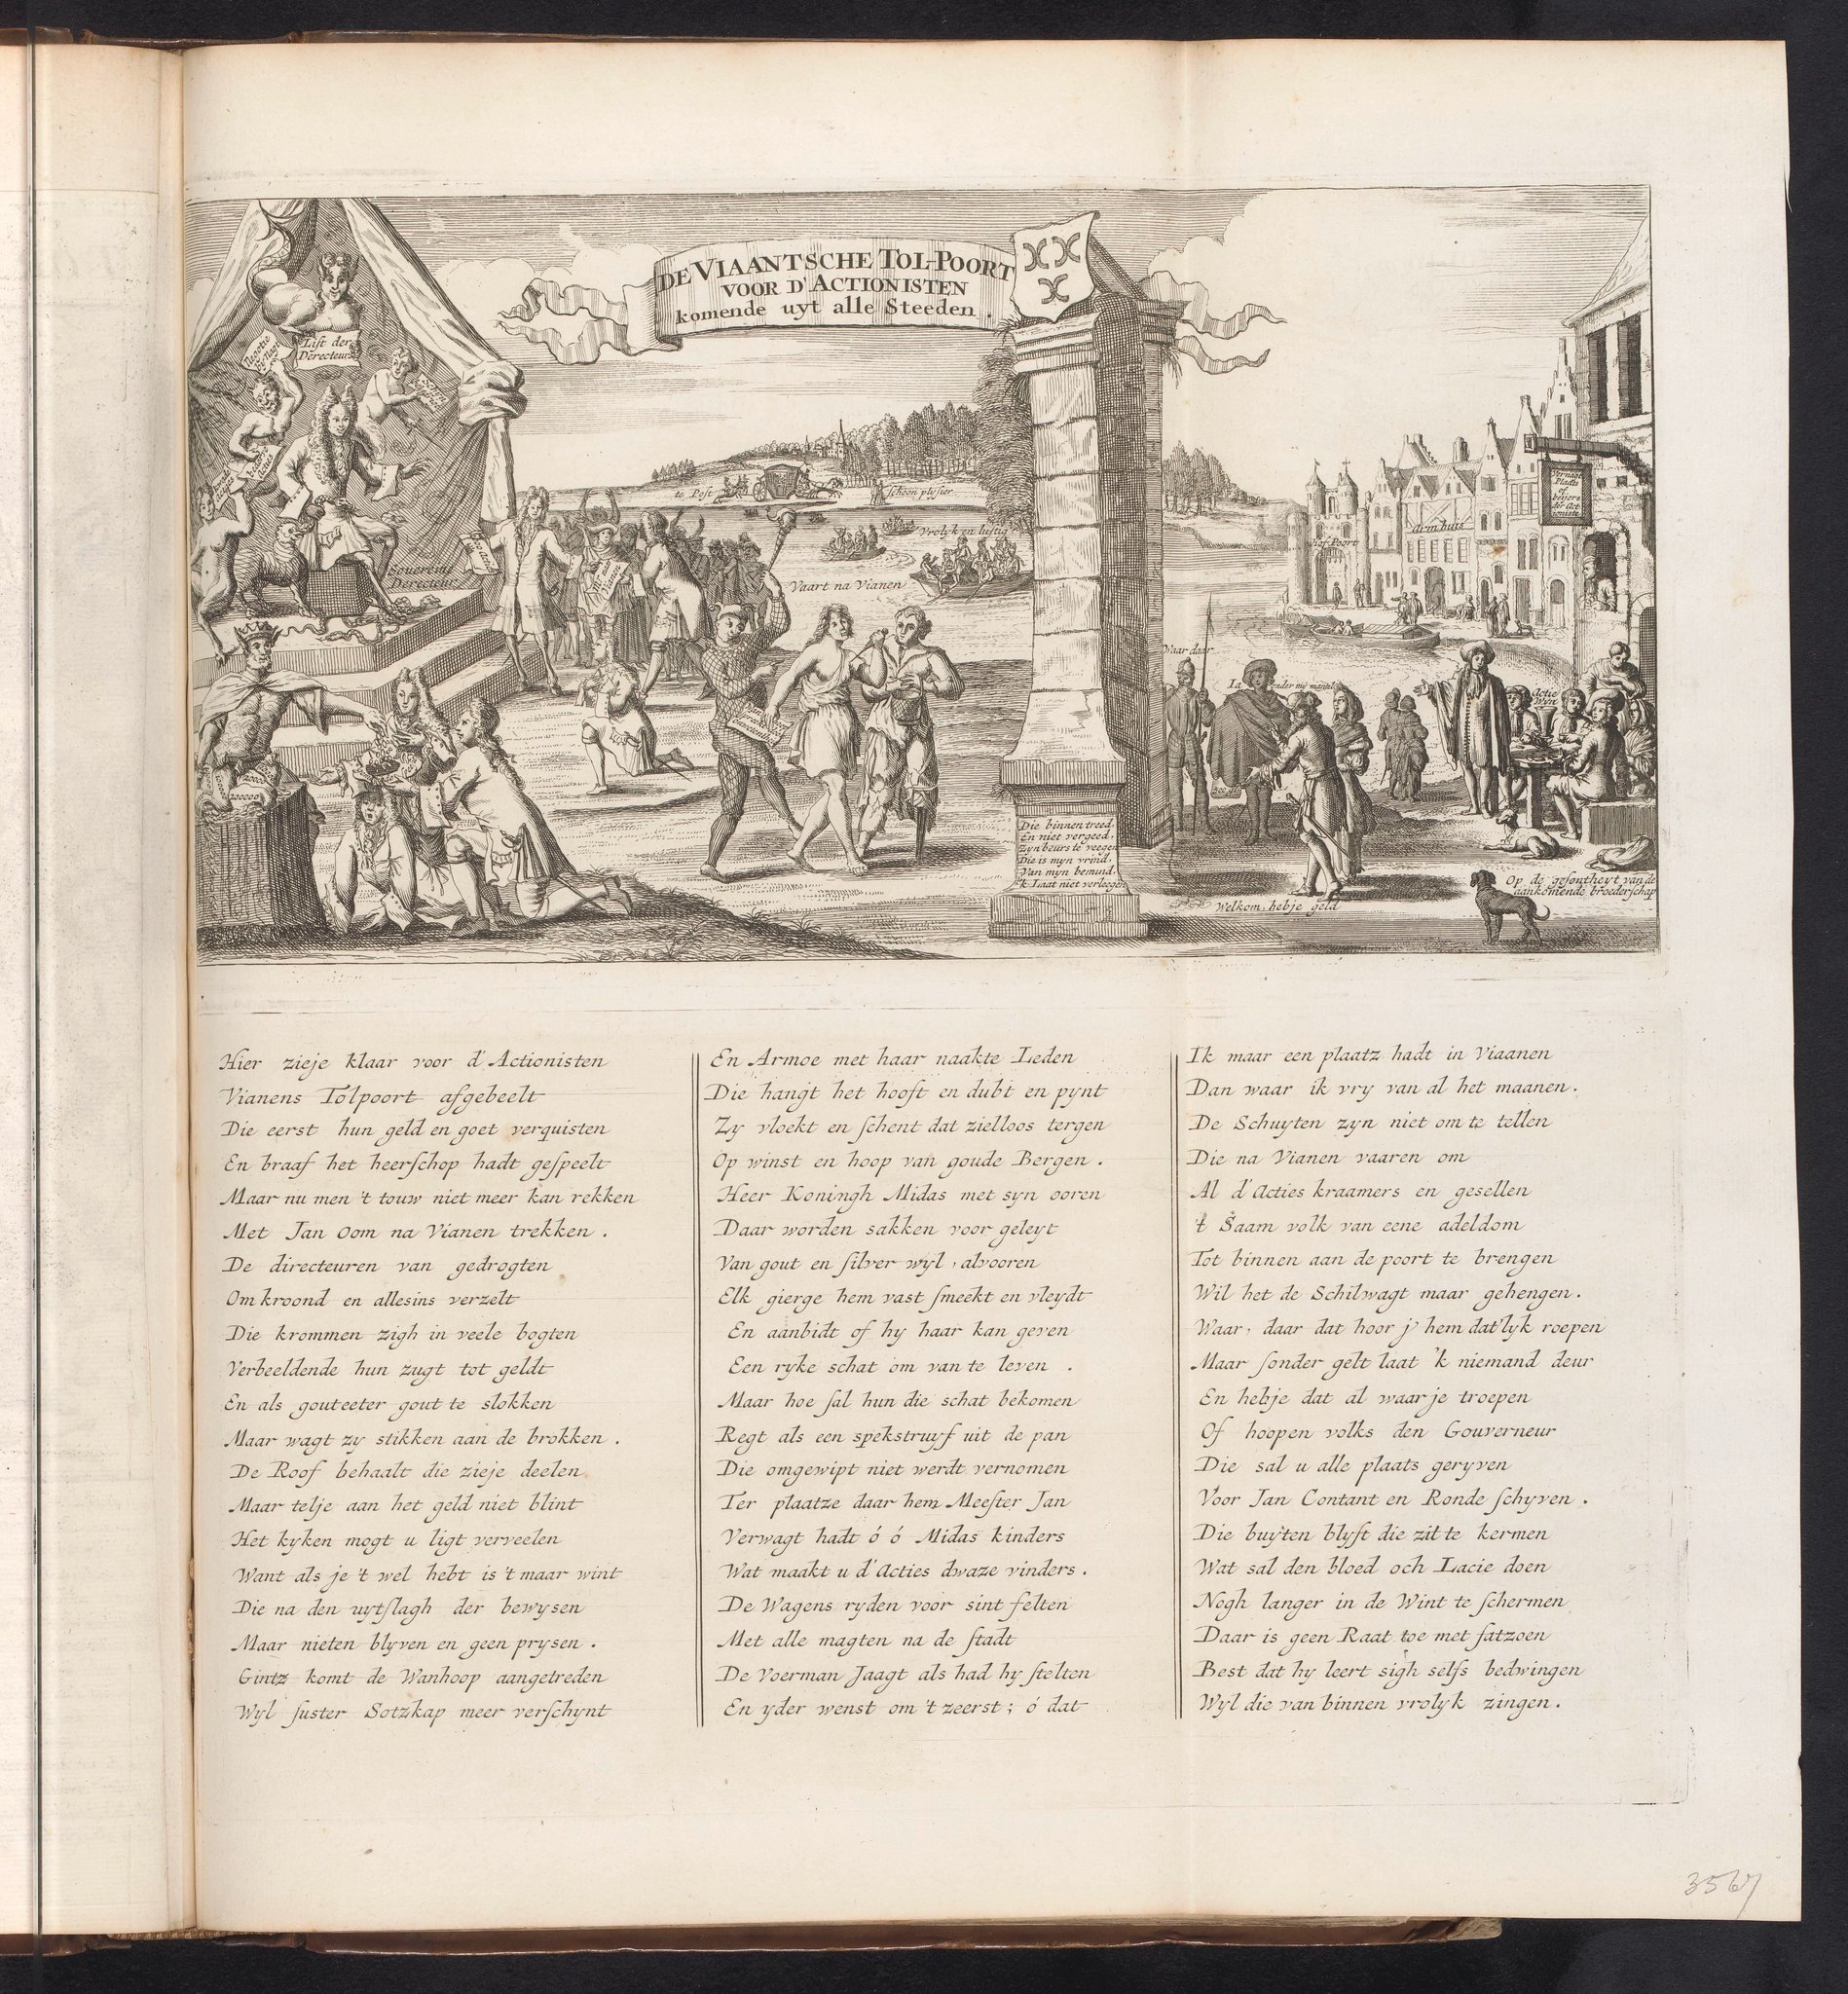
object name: print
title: De Viaantsche Tol-Poort voor d'Actionisten komende uyt alle steeden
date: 1682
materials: paper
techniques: engraving, etching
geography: amsterdam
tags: econoom, john law, vianen, windhandel van 1720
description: Spotprent op de windhandel te Vianen. John Law zit links als de soevereine directeur van de windhandel te Vianen op zijn troon omgeven door duivels, rechts de tolpoort waardoor alleen mensen met geld binnen kunnen komen. Het onderschrift met een vers in drie kolommen gedrukt van een aparte plaat. Prent in de gebonden eerste uitgave (304 B 11) van Het Groote Tafereel der Dwaasheid met spotprenten op de Windhandel of Actiehandel van 1720.